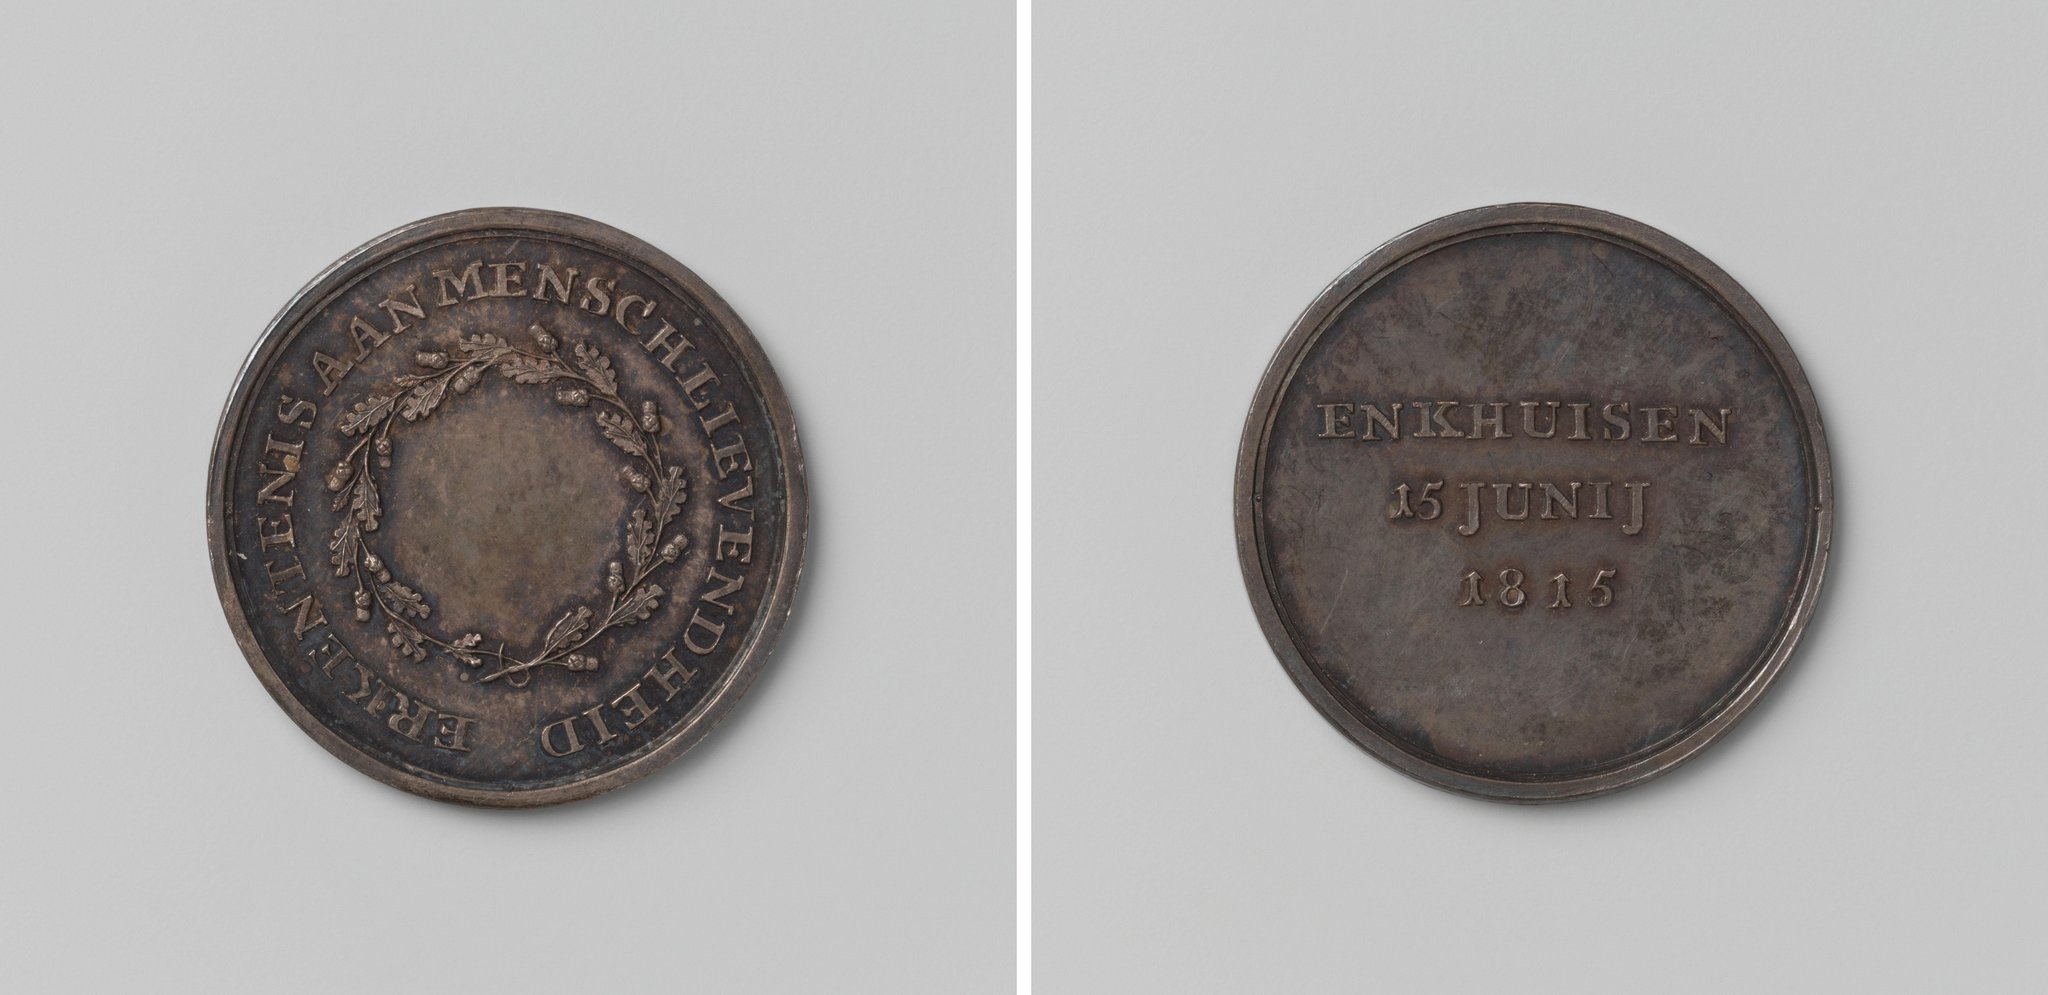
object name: honorary medal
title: Stad Enkhuizen, penning uitgereikt voor menslievendheid betoond tijdens het instorten van een brug op de dag van het uitvaren van de haringvloot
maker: Anonymous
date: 1815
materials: silver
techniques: striking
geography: netherlands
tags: enkhuizen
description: Zilveren penning. Voorzijde: blanco veld binnen eikekrans en omschrift. Keerzijde: opschrift.